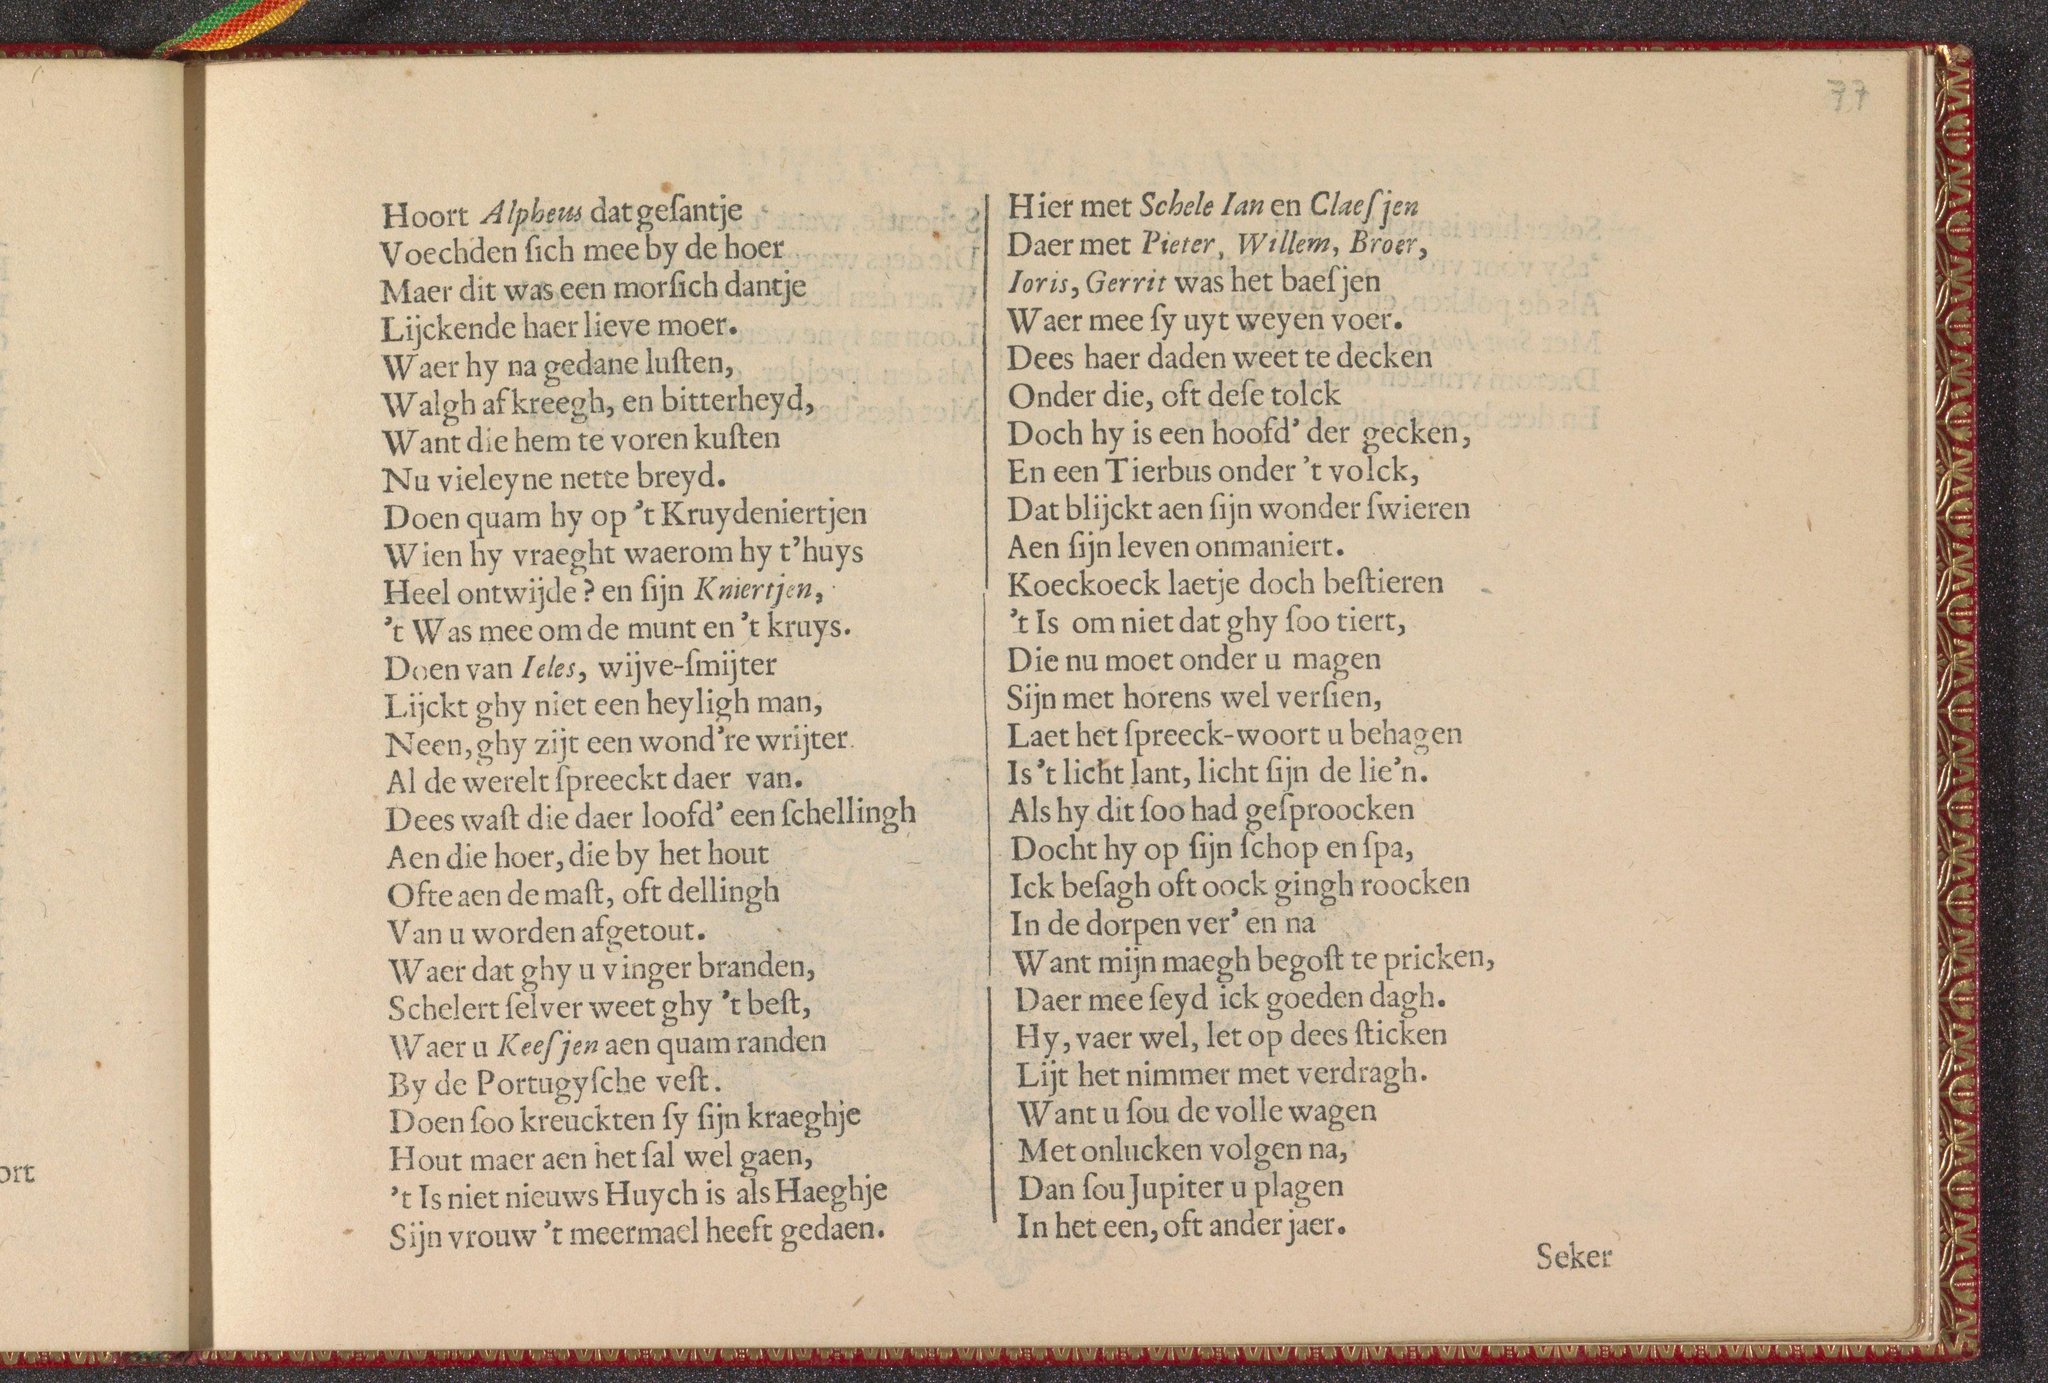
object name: text sheet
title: Vertelling van de herder Melibaeus, pagina 3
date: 1641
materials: paper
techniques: letterpress printing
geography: amsterdam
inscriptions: date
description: Vertelling van de herder Malibeaus op vier pagina's: pagina 3. Het blad maakt deel uit van een album.